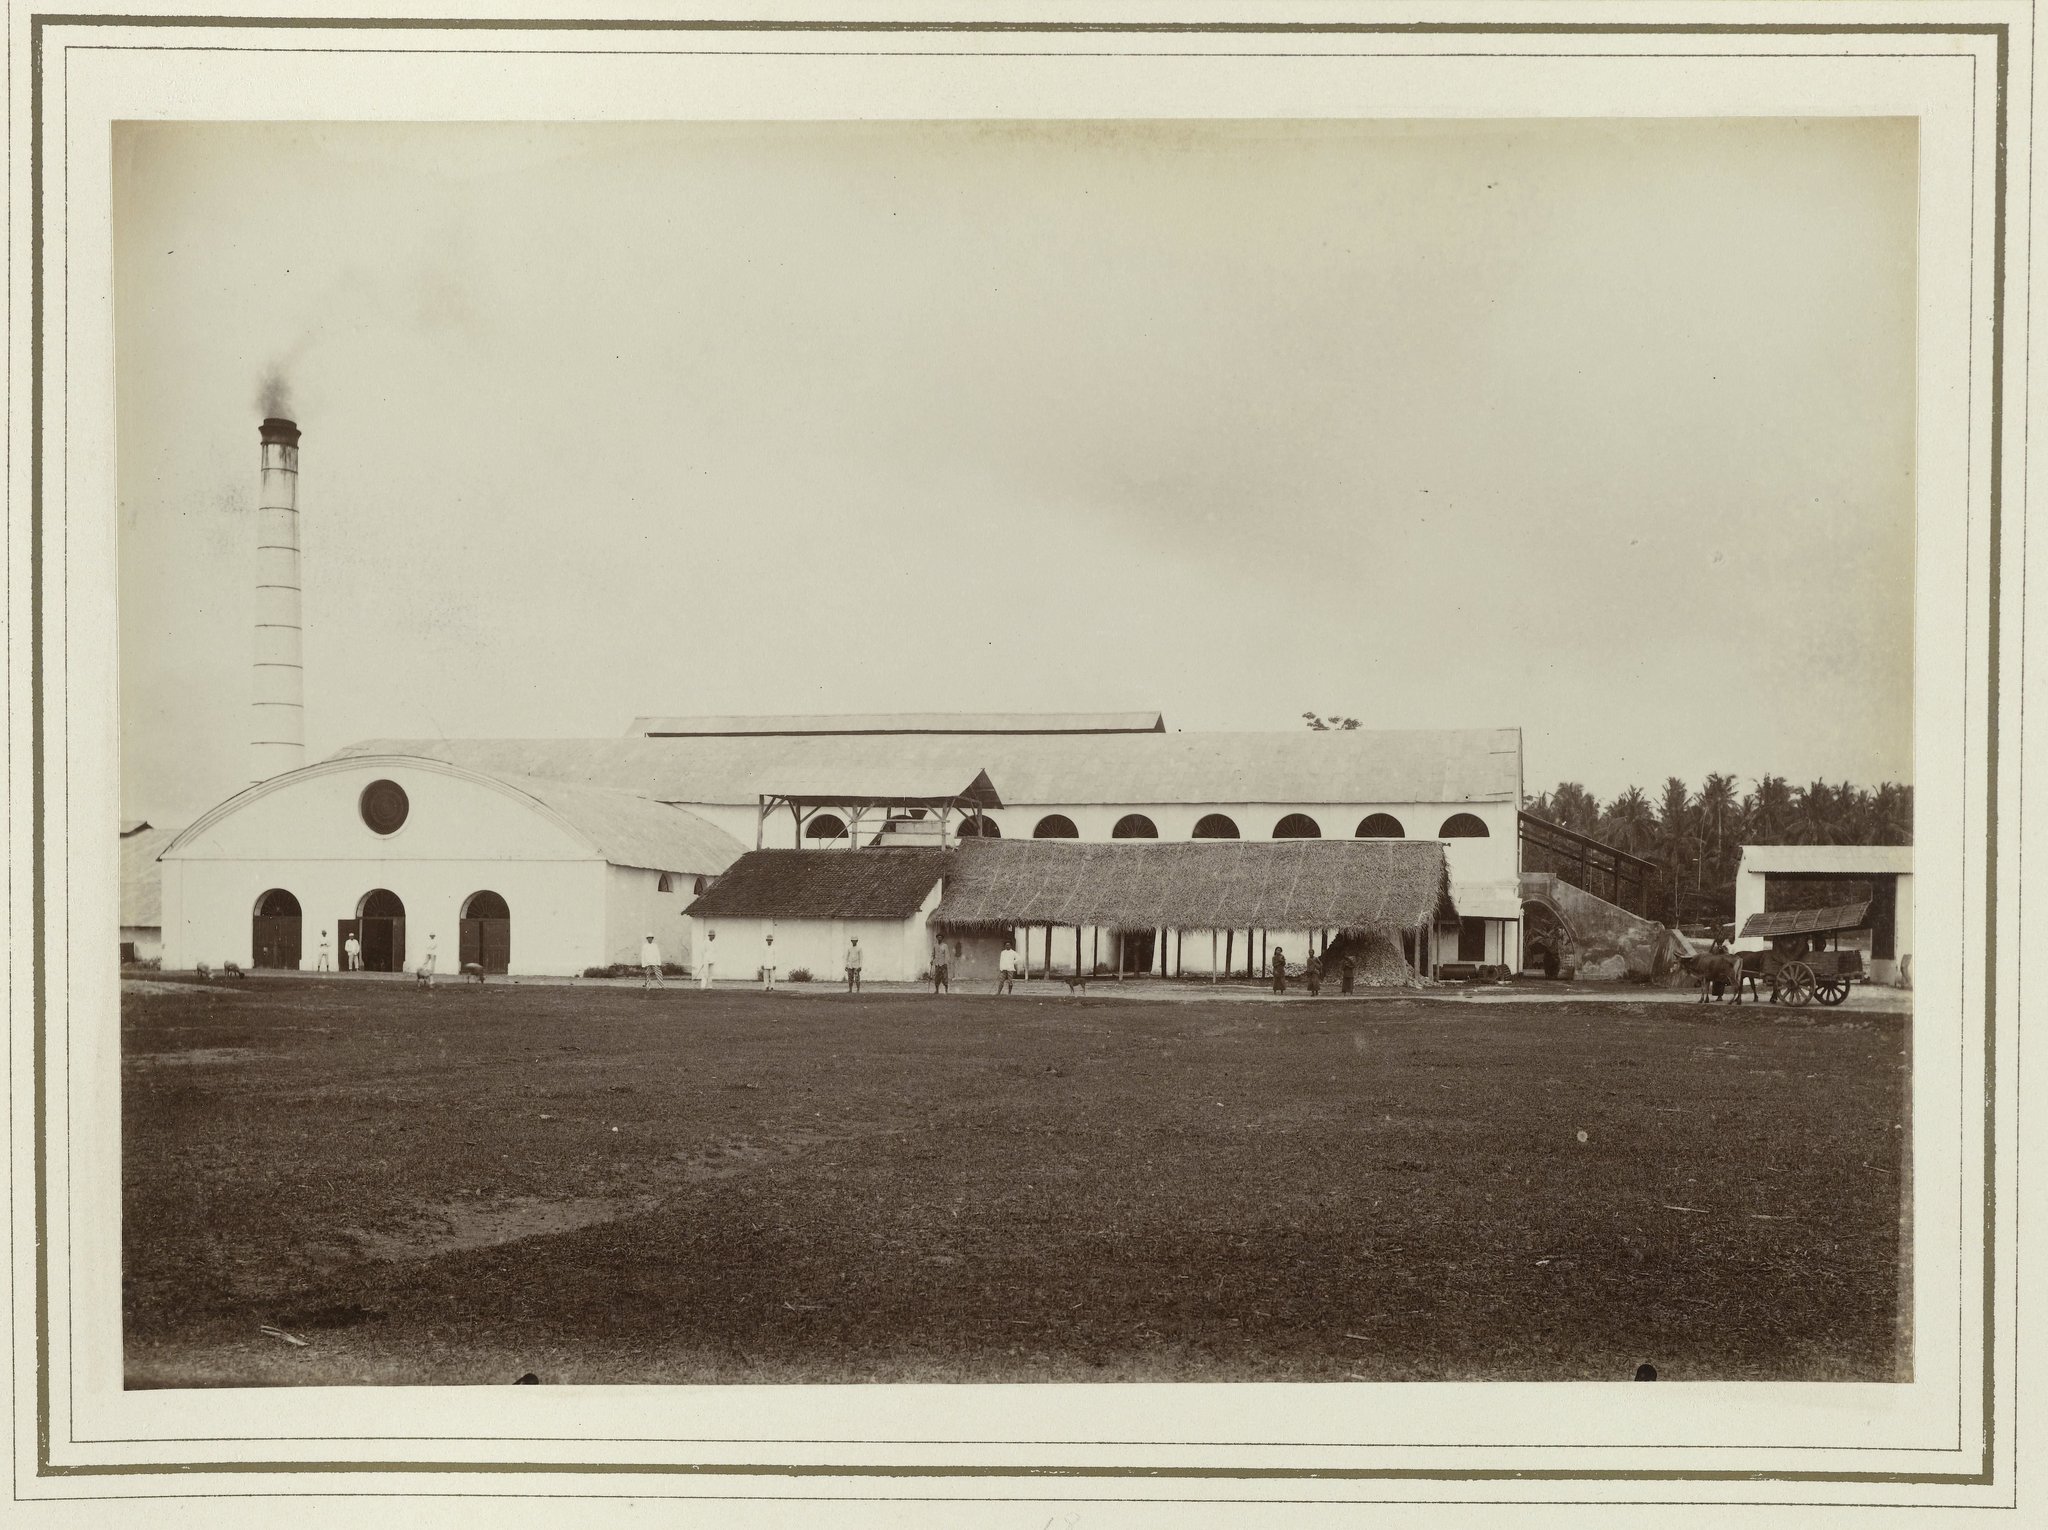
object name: photograph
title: Fabriek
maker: kassian céphas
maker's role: fotograaf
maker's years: 1845-1912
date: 1886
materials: photographic support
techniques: albumen print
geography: jogjakarta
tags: the hague, colonial system, plantation, smoke-stack, factory-building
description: Gebouwen van een fabriek. Onderdeel van het fotoalbum aangeboden aan J.M. Pijnacker Hordijk bij zijn vertrek uit Jogyakarta in 1886.